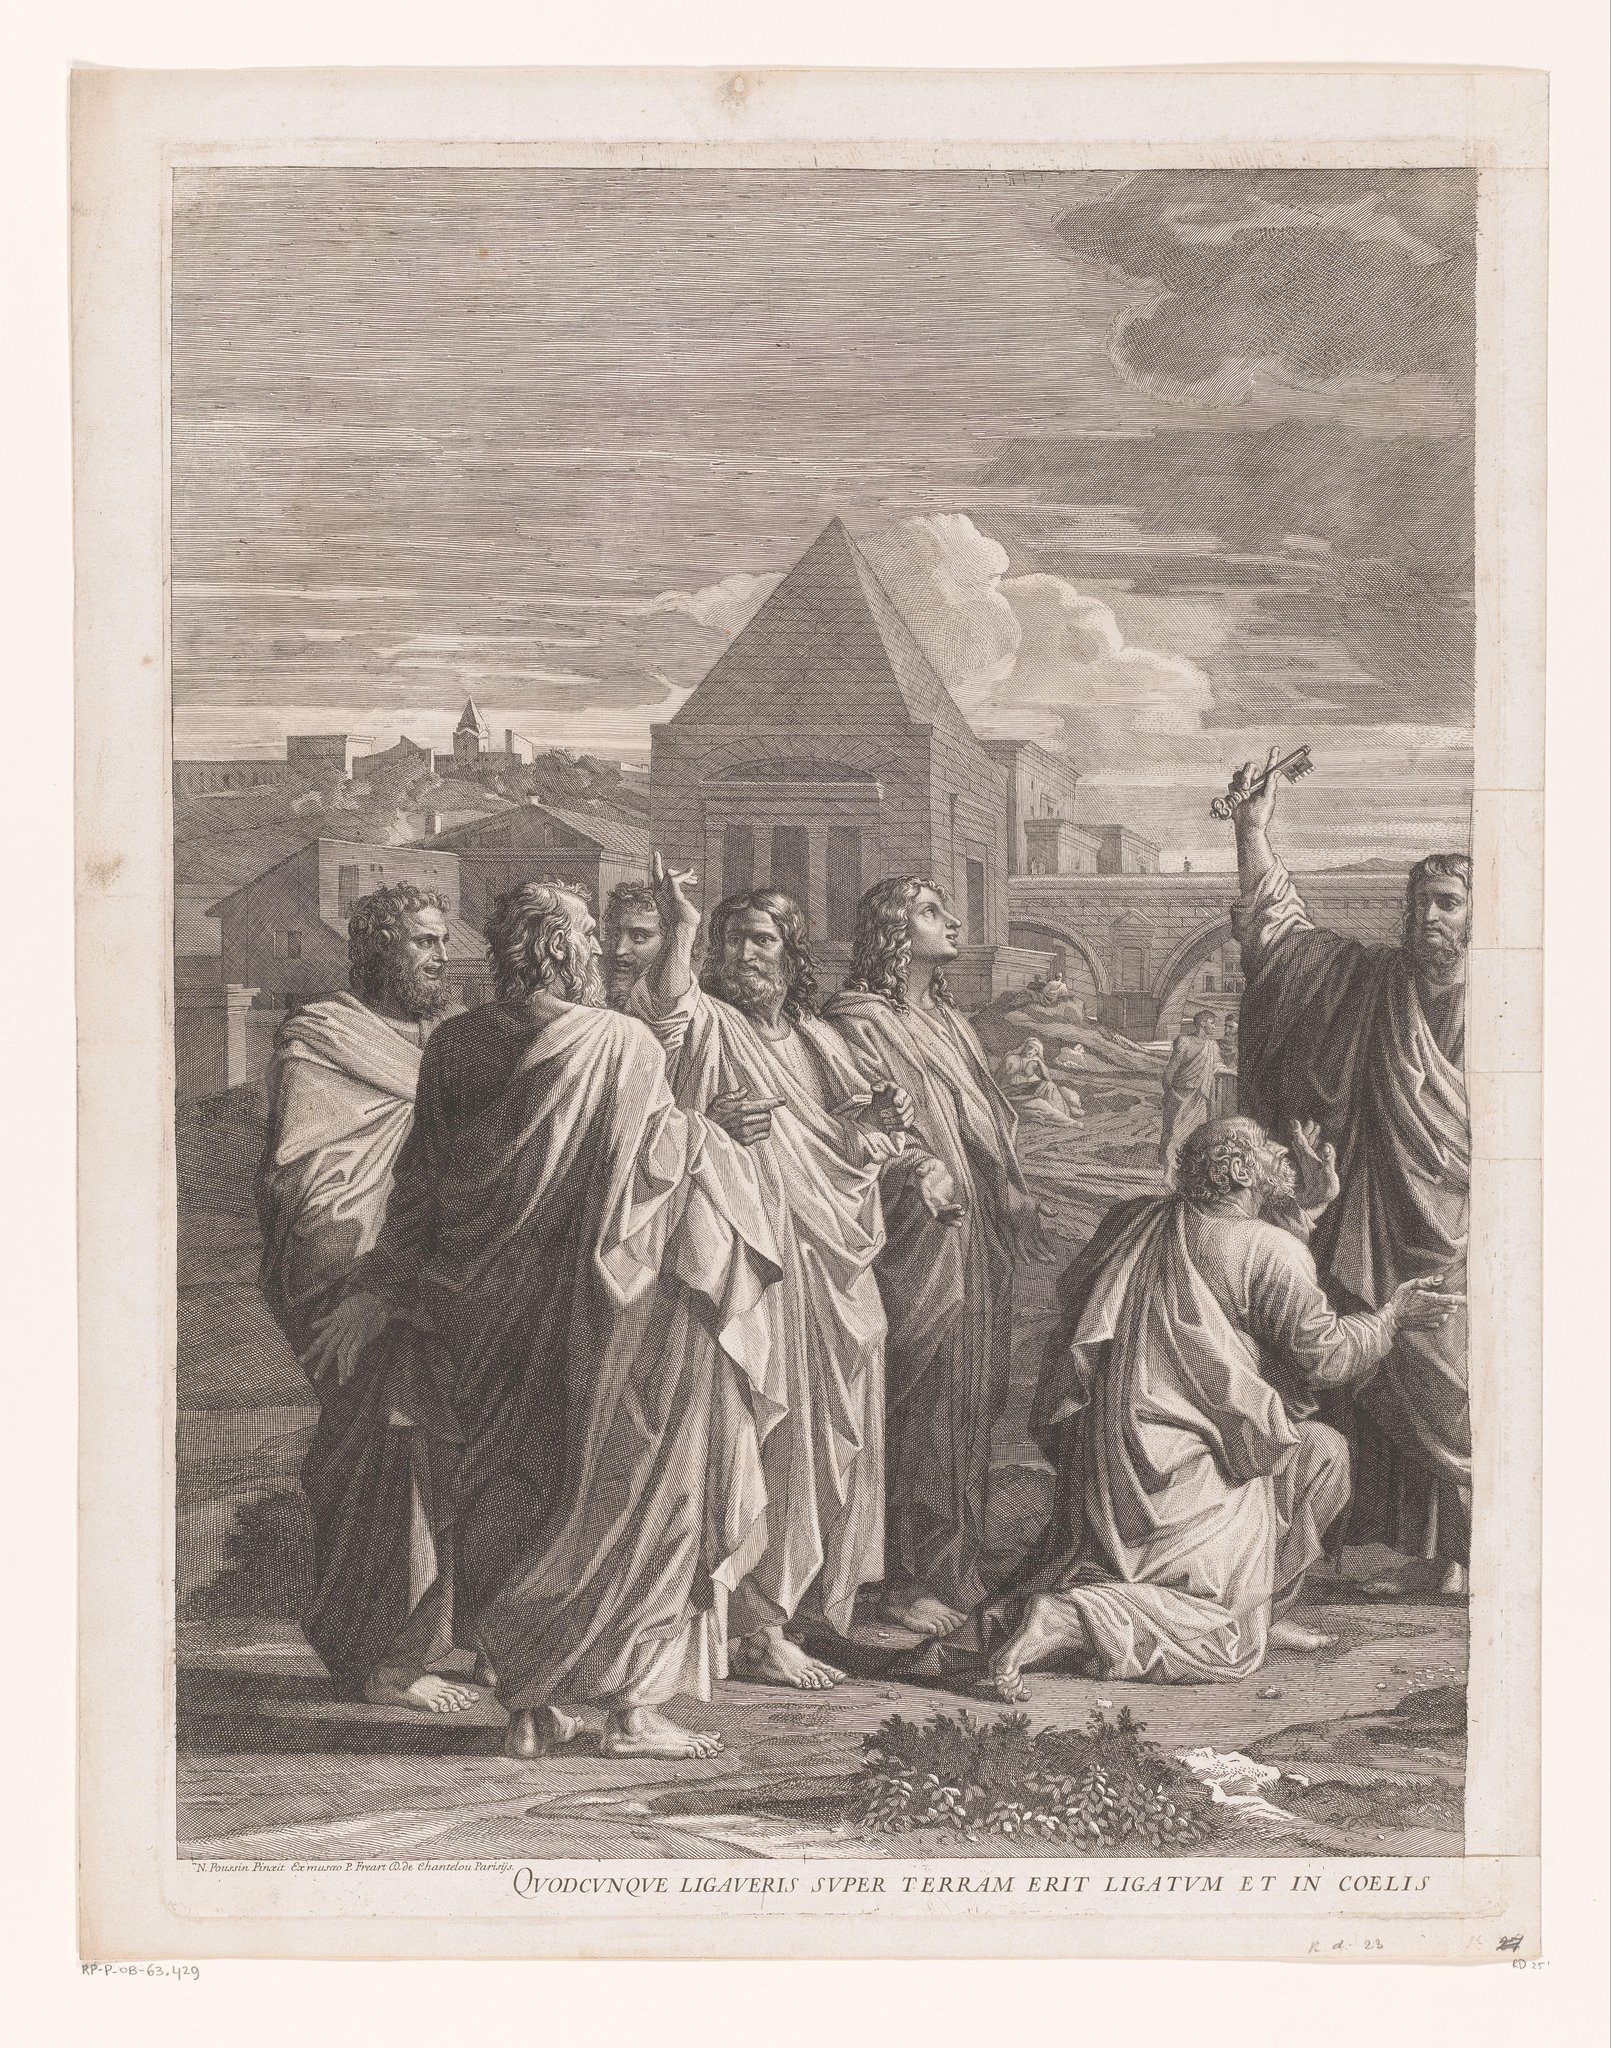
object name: print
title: Quodcunque ligaveris super terram (...)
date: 1633-1700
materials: paper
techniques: etching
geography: france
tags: christ gives the keys of heaven to peter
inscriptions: collector's mark: Lugt 240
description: Prent maakt deel uit van een ongenummerde serie van zeven prenten.